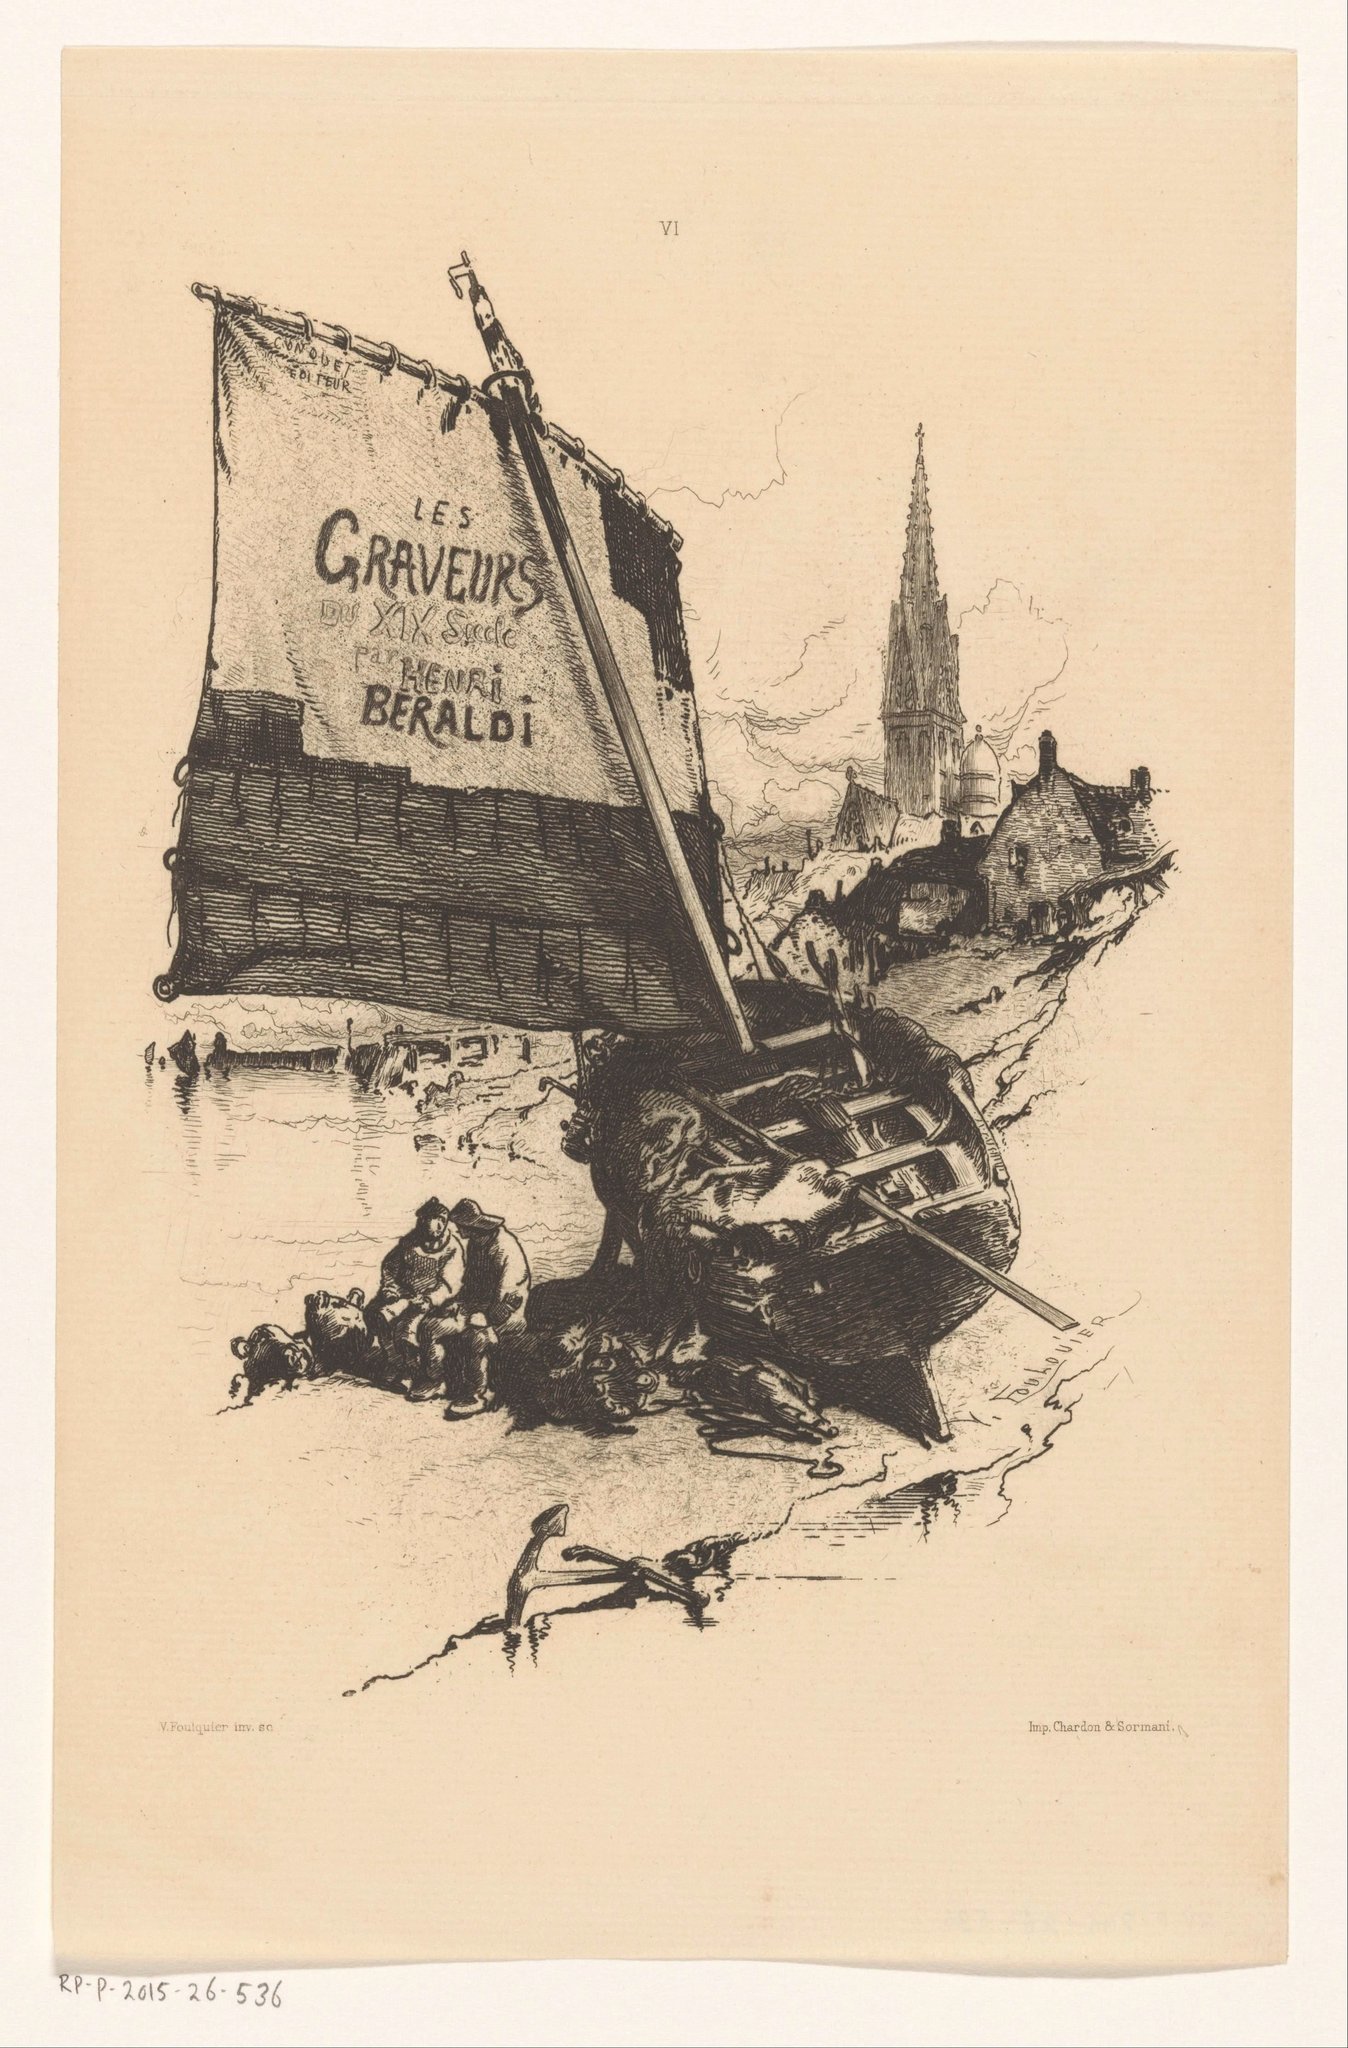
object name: titelblad, titelpagina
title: Titelpagina voor: Henri Béraldi, Les graveurs du XIXe siècle, 1887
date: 1887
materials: paper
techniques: drypoint, etching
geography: paris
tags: sailing-ship, sailing-boat, parts of ship's exterior: anchor, beach, parts of church exterior and annexes: tower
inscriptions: collector's mark: Lugt 4779, collector's mark: Lugt 2228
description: Titelpagina voor: Béraldi, Henri. Les graveurs du XIXe siècle. Guide de l'amateur d'estampes modernes. Dl. 6. Paris: L. Conquet, 1887.